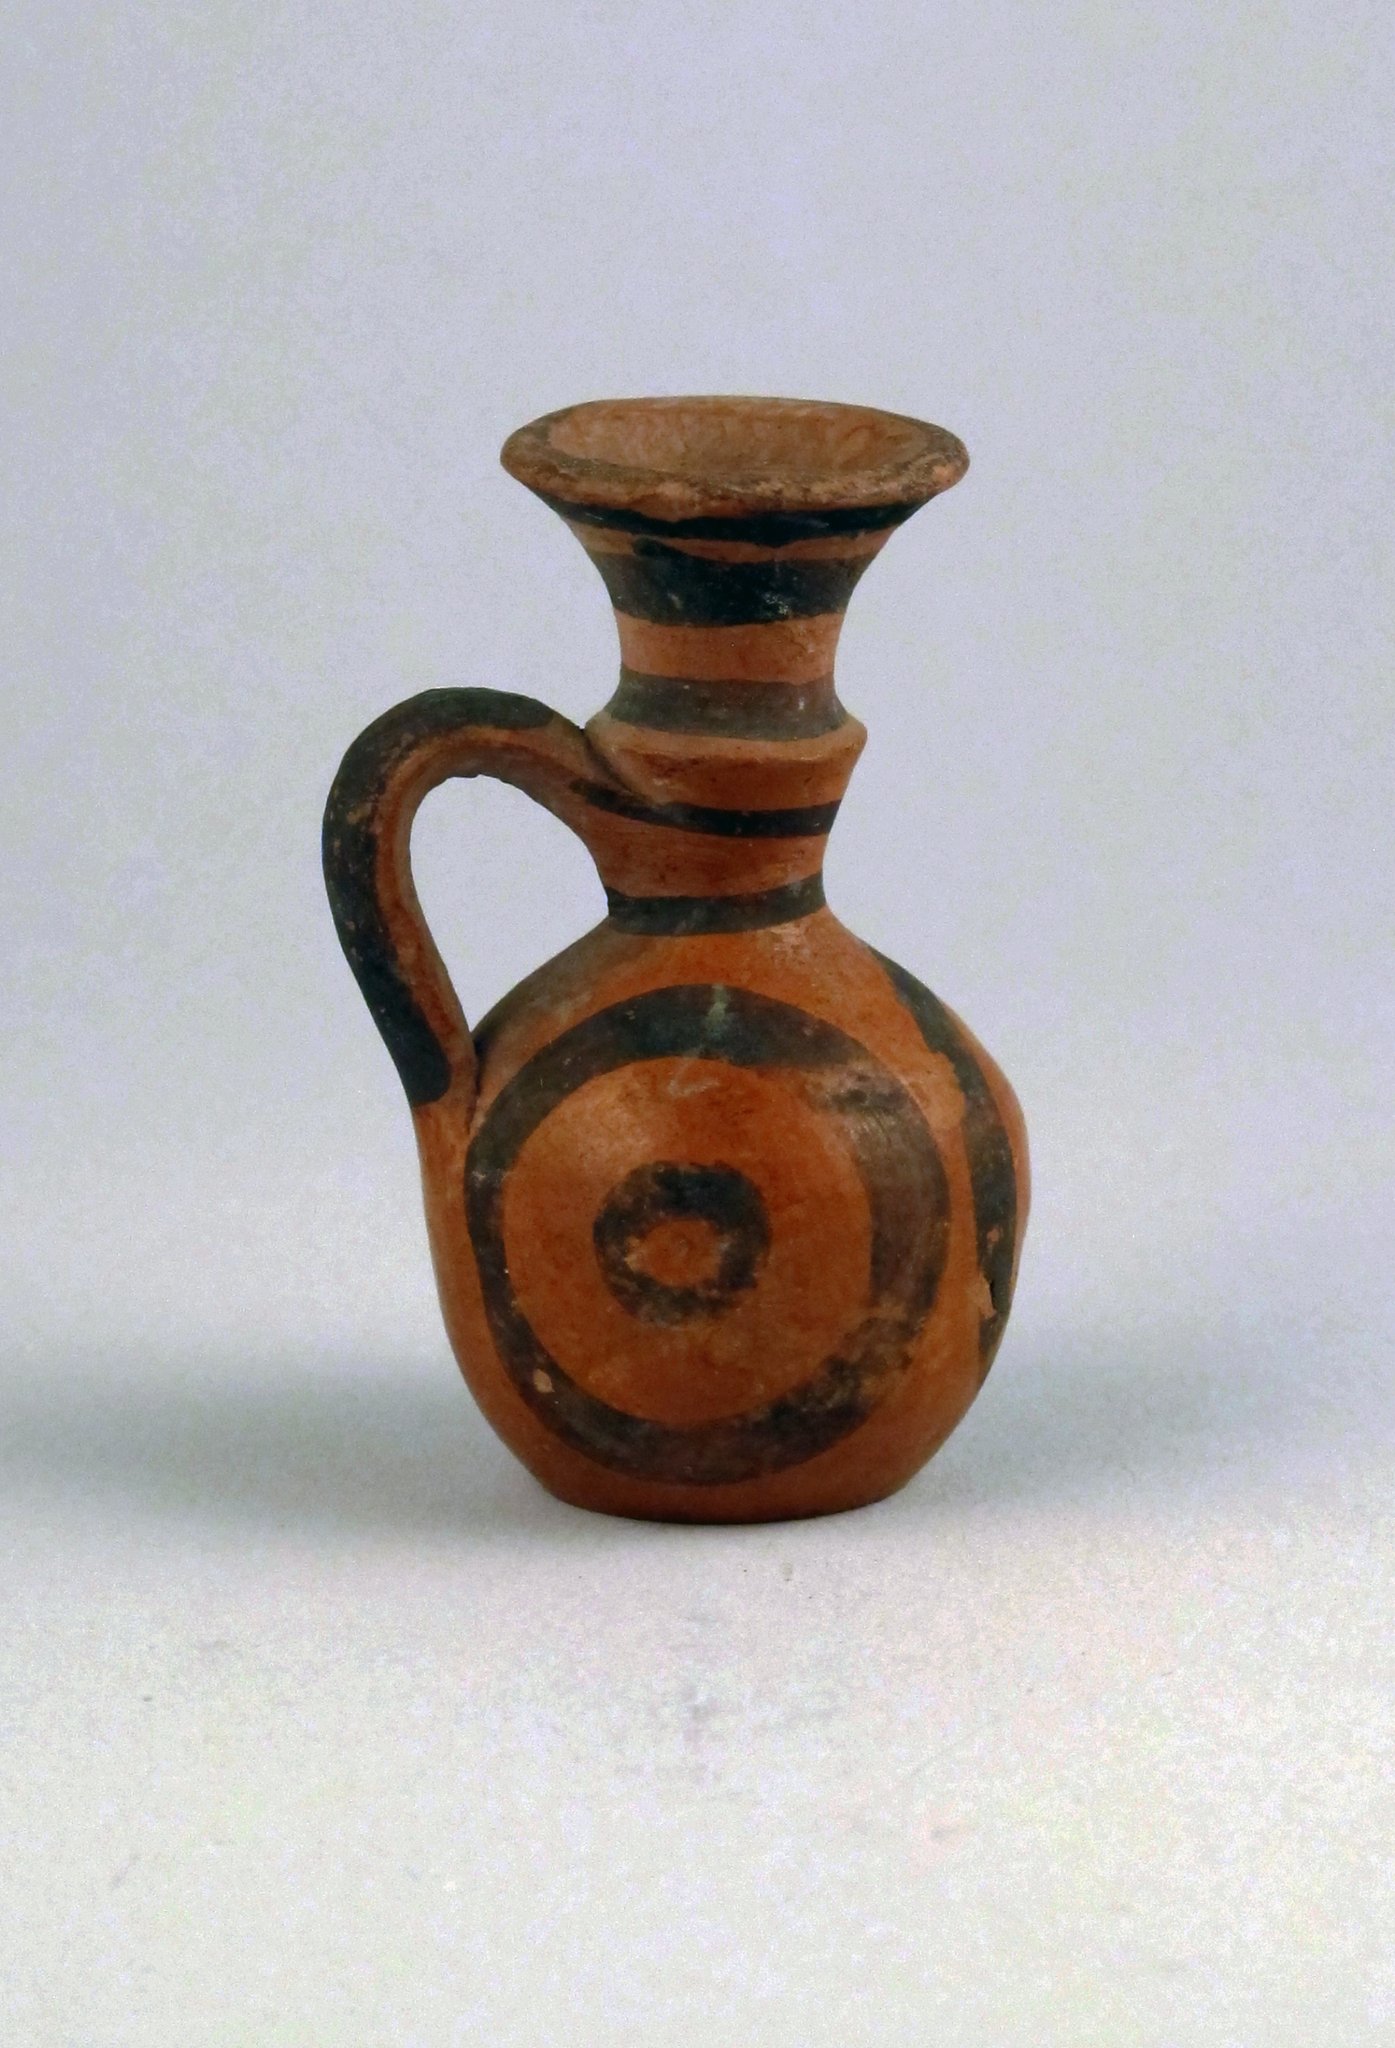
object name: jug, miniature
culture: cypriot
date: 500-300 BCE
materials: terracotta